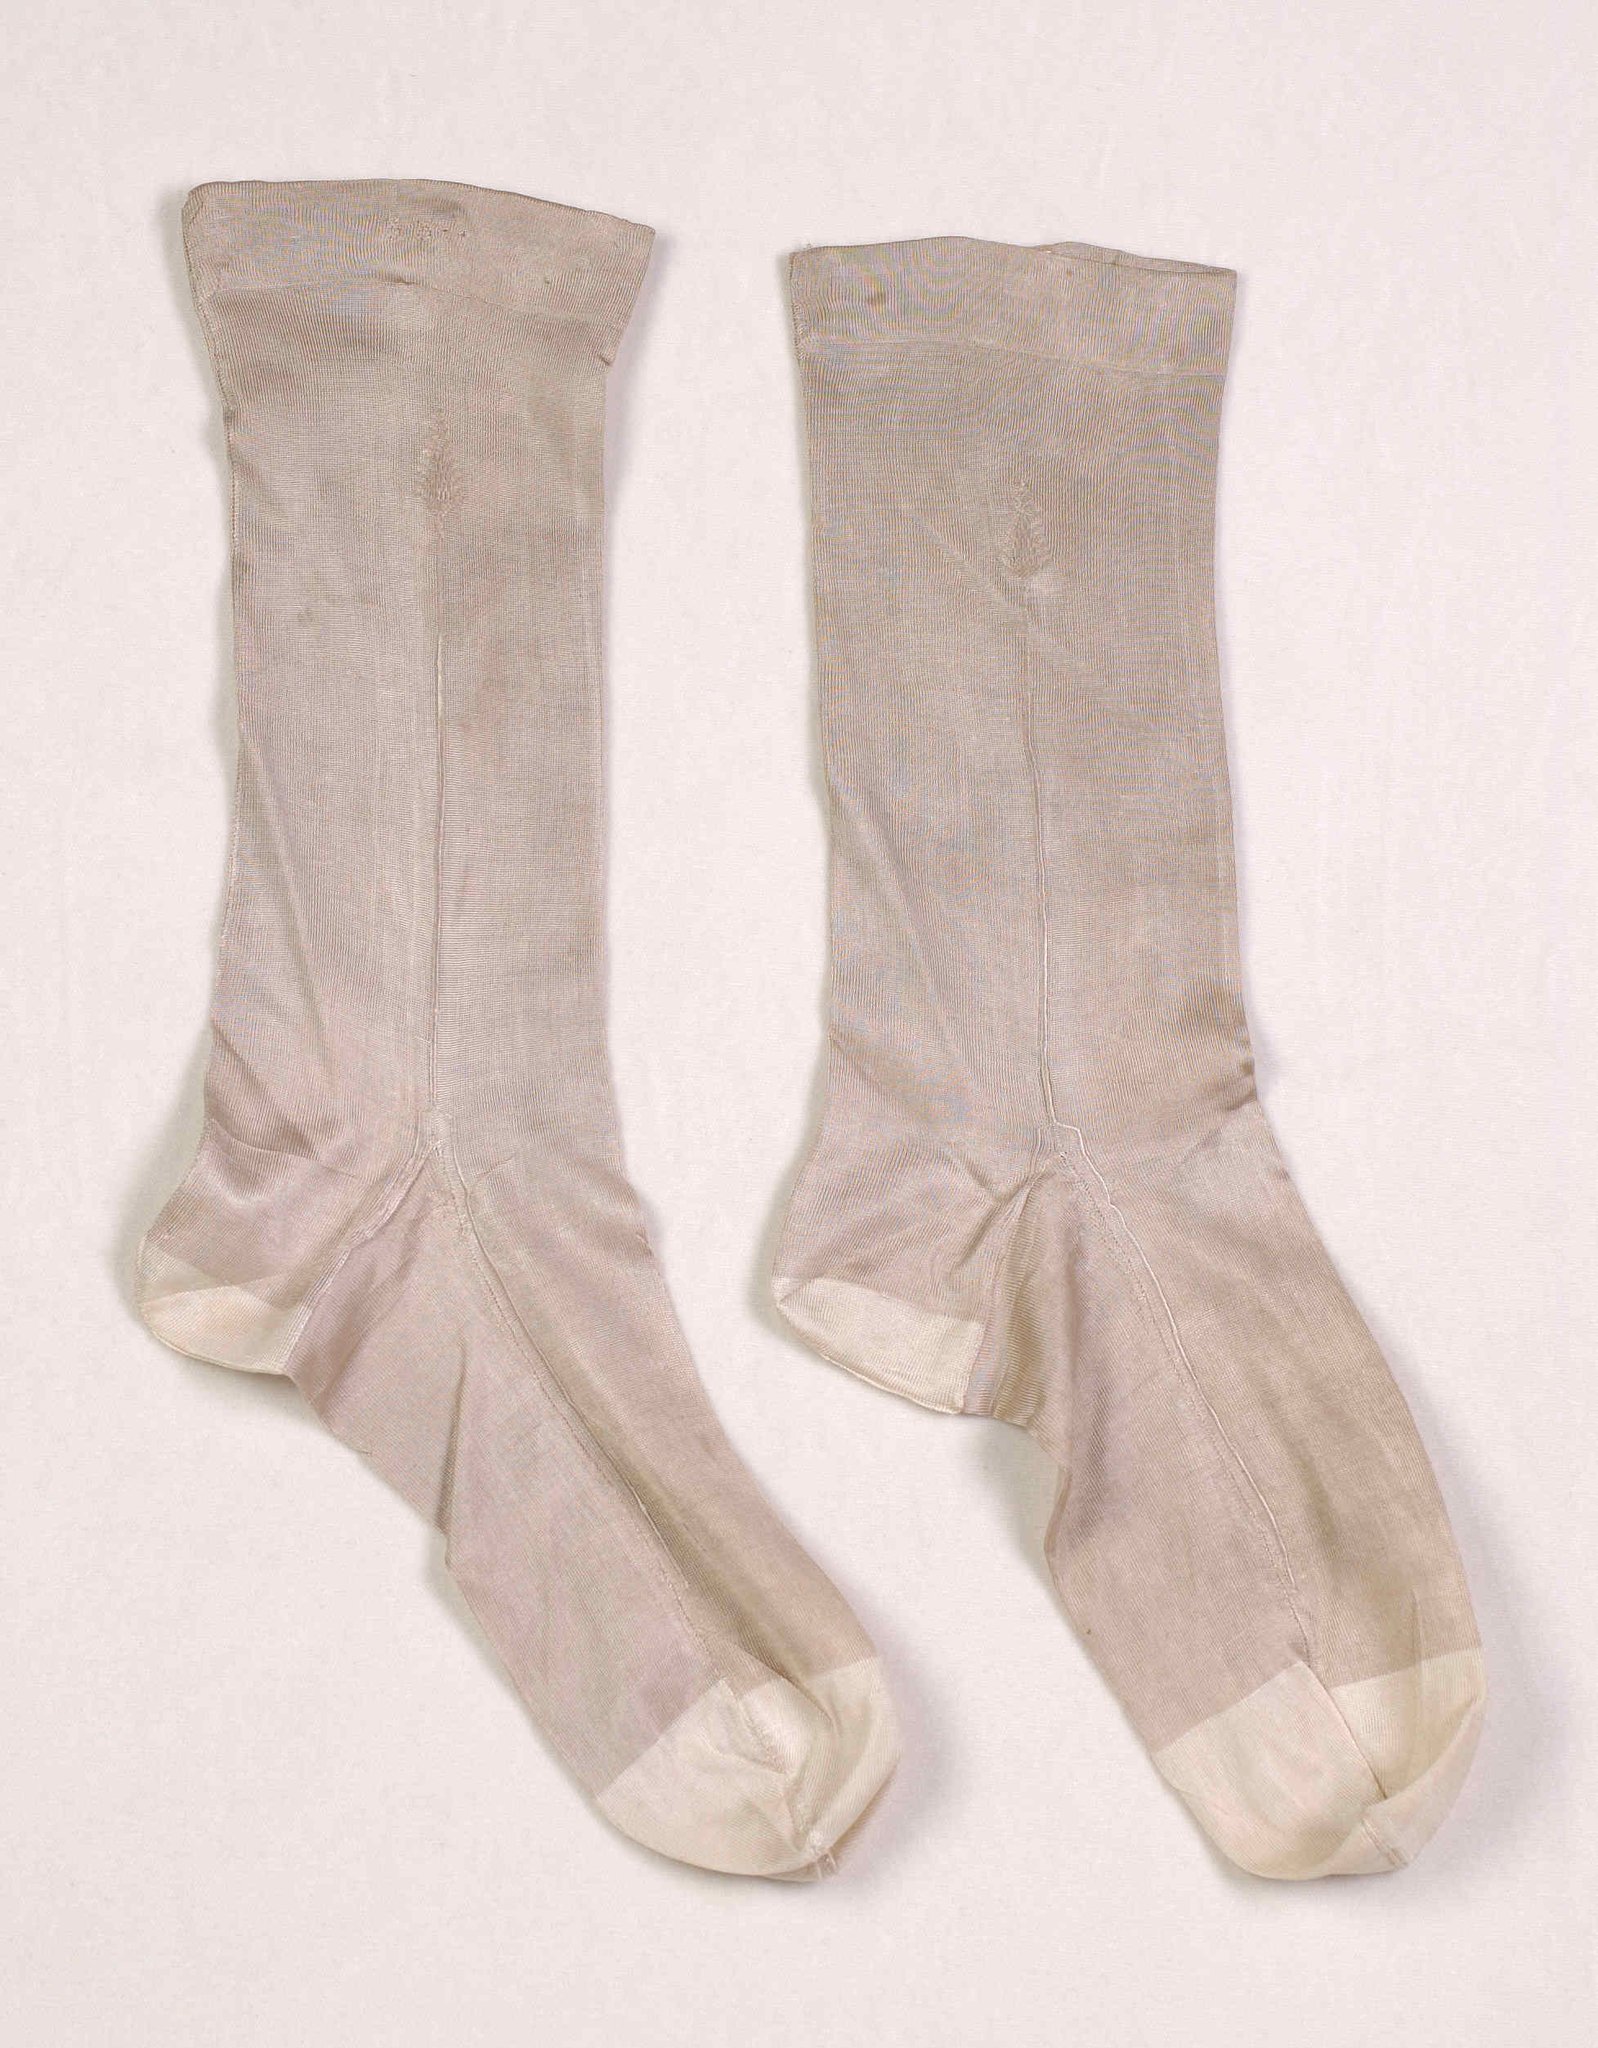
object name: wedding sock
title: Wedding socks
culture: american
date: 1851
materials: silk